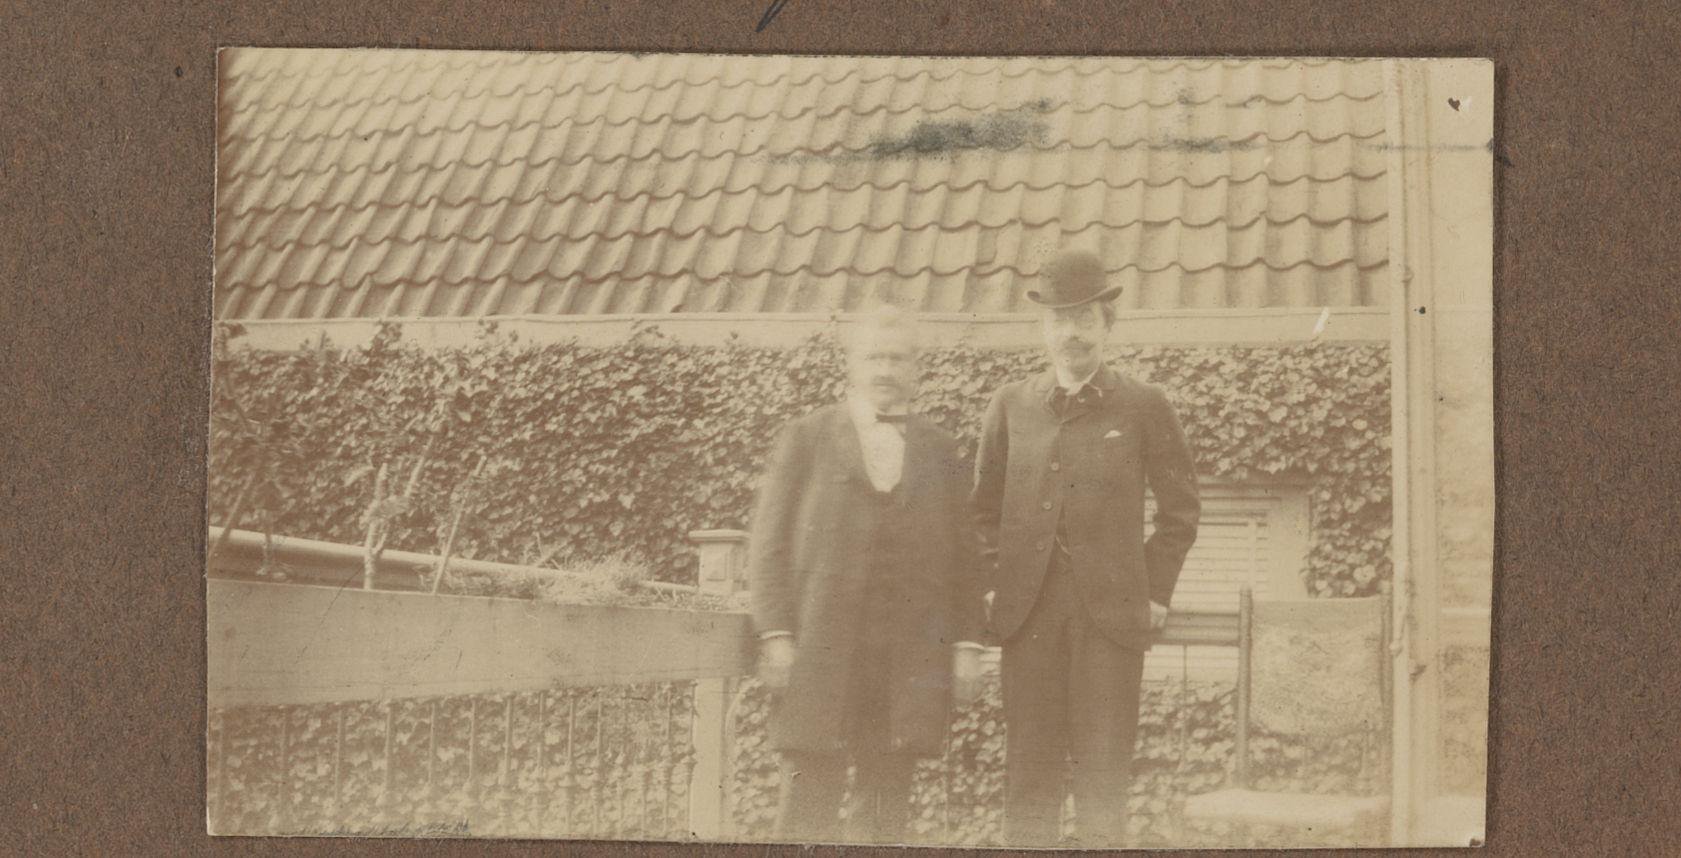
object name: photograph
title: Twee staande mannen in tuin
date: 1906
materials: photographic support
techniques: photography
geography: netherlands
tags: dordrecht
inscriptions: date: ‘Dordrecht 1906’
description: Foto op bruin albumblad 12 van familiealbum van Alphons Diepenbrock.